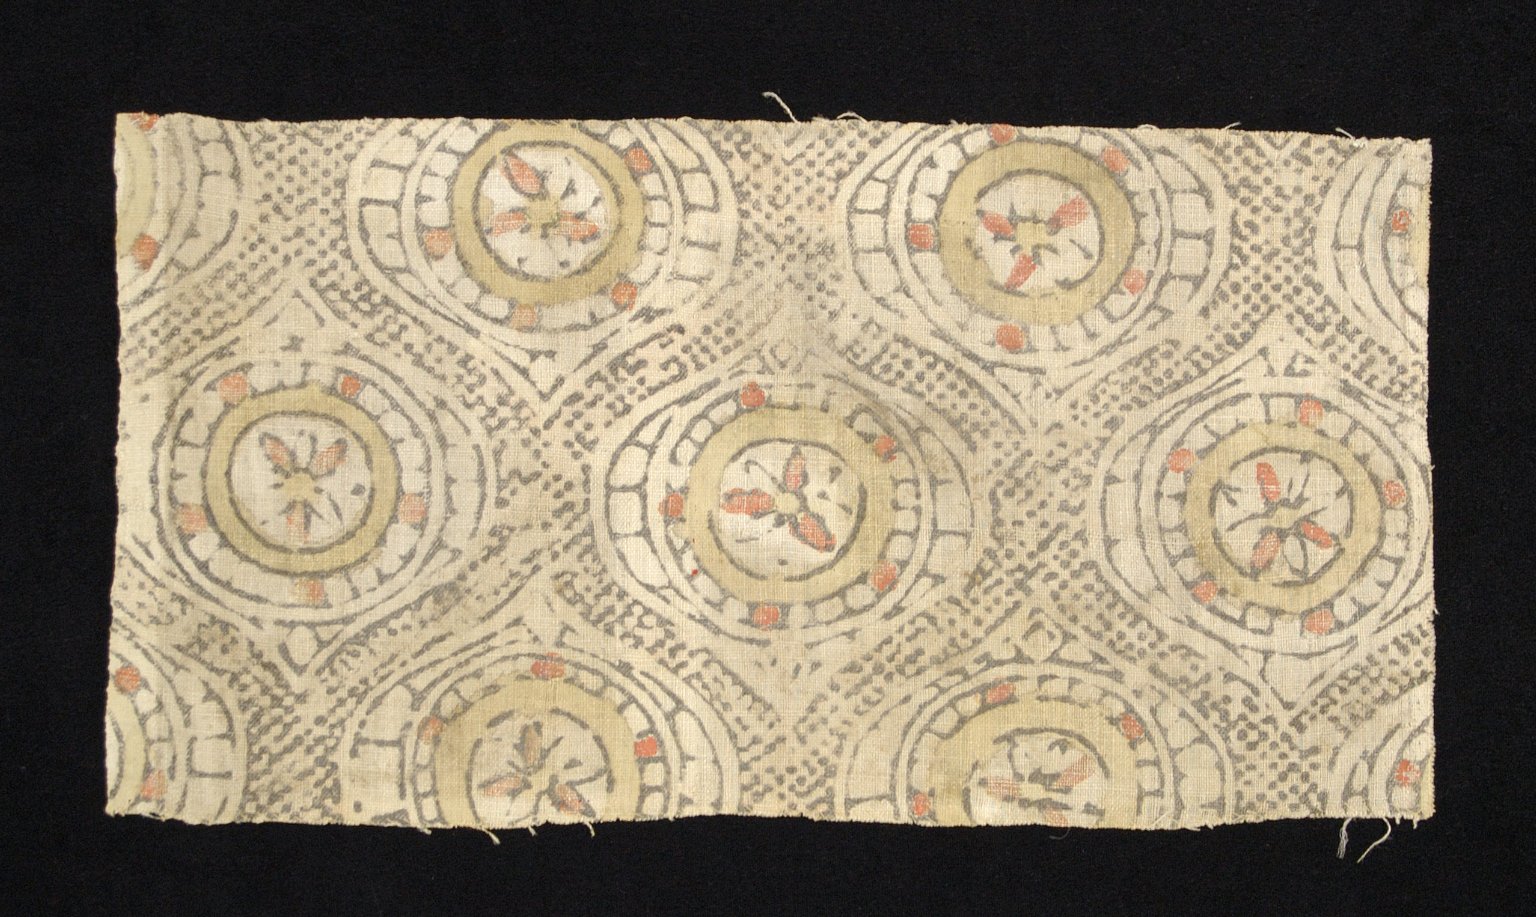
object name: textile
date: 1700-1899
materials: linen